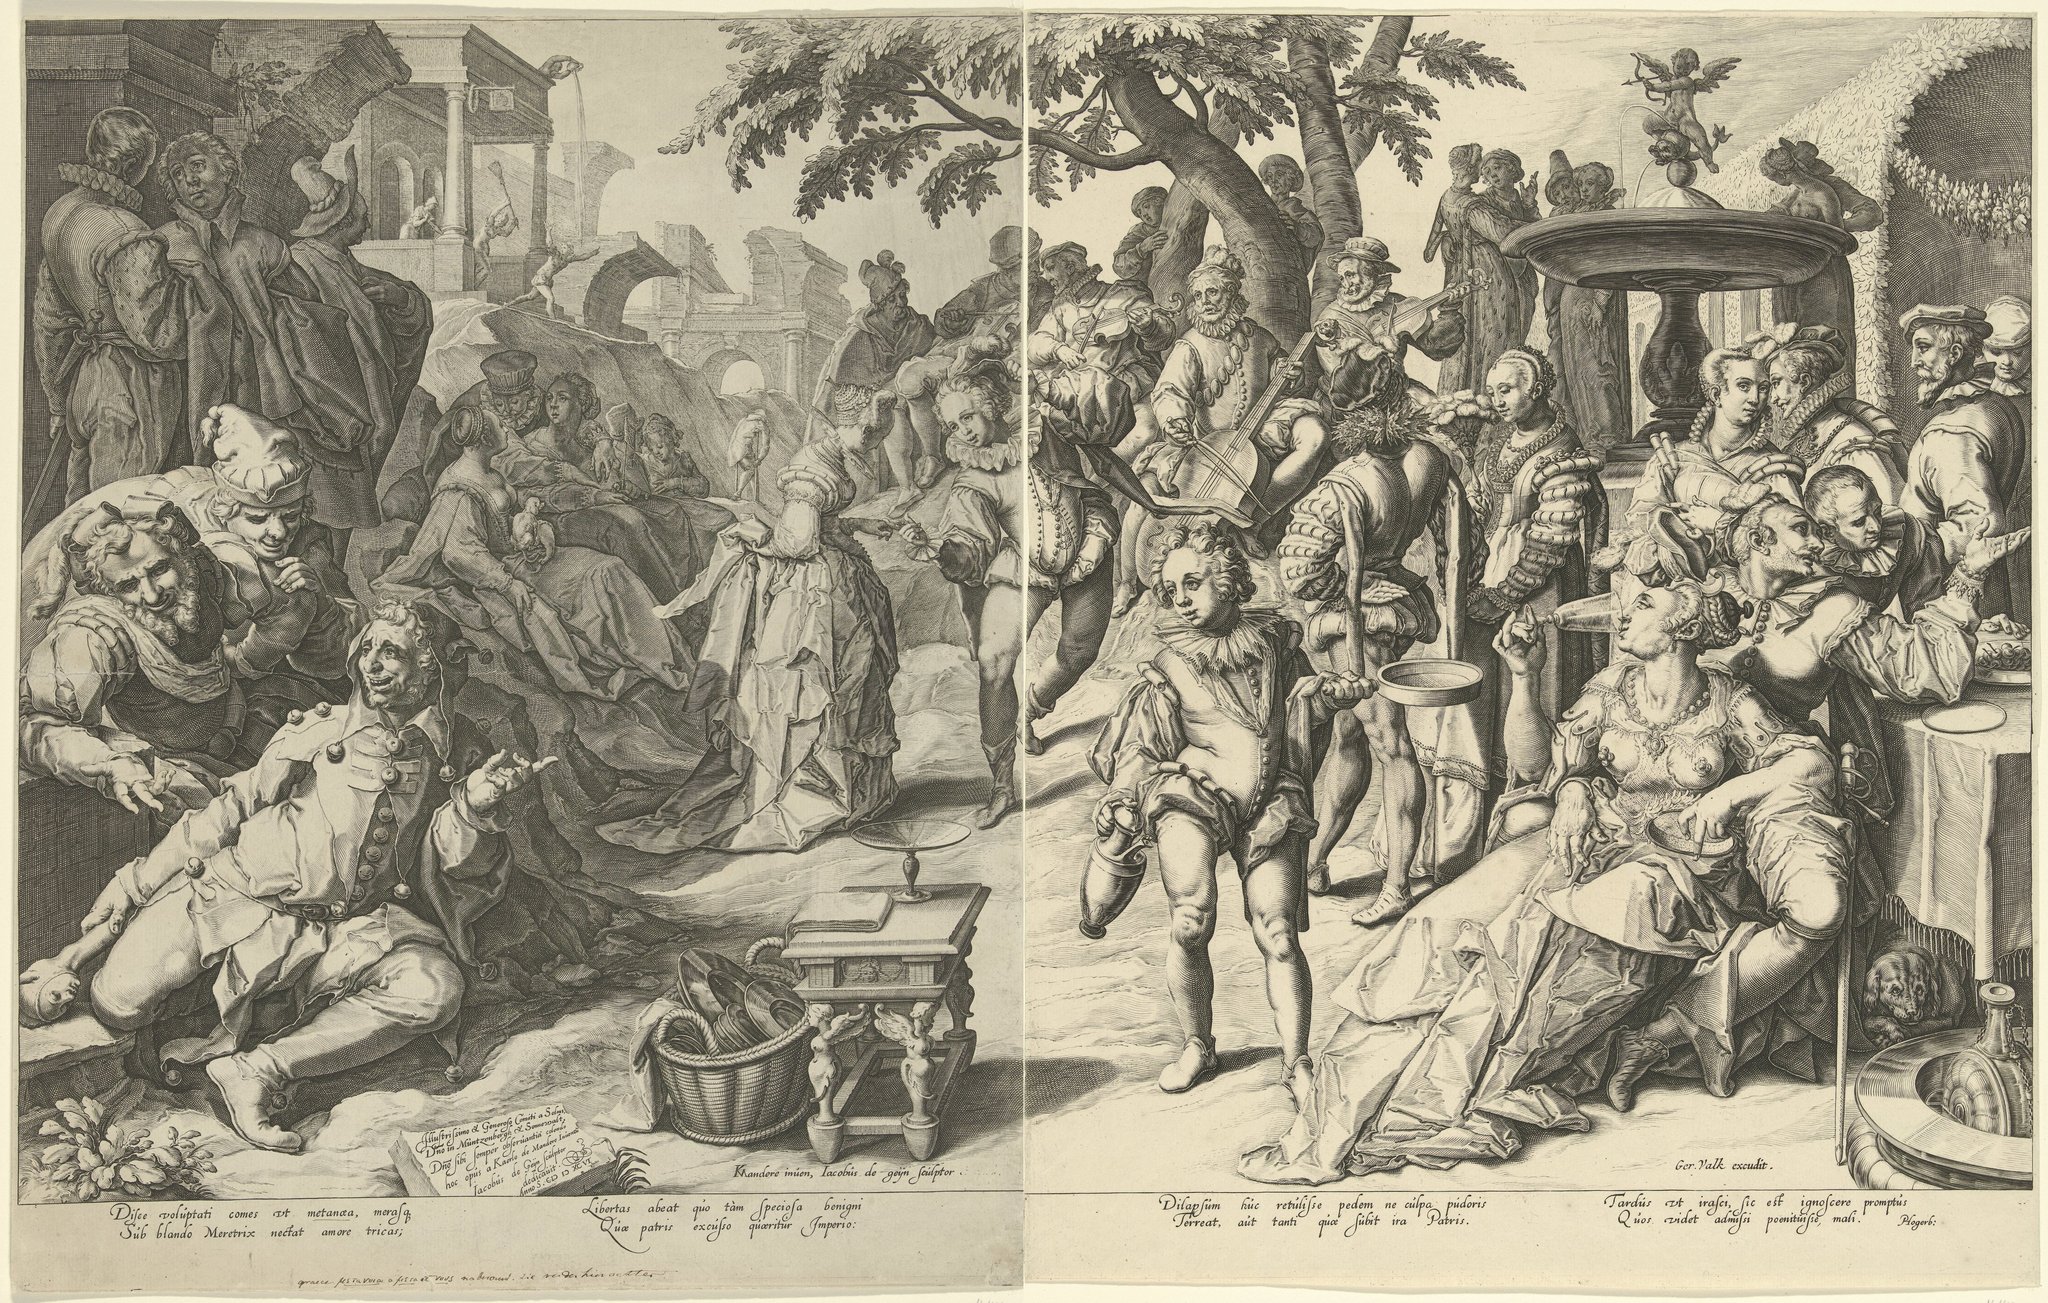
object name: print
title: De verloren zoon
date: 1596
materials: paper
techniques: engraving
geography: leiden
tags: the parable of the prodigal son (luke 15:11-32)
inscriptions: collector's mark: Lugt 2228a, inscription: ‘graece metanoia [...] na berouw. Zie verder hier achter’ Opmerking heeft betrekking op een woord in het onderschrift., collector's mark: Lugt 2228a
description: Voorstelling op twee bladen van een gezelschap dat zich in de buitenlucht bij een fontein vermaakt met eten, drinken, muziek en vrijages. Op de achtergrond is te zien hoe een man weggejaagd wordt uit een gebouw. Onder de voorstelling een achtregelig Latijns gedicht.